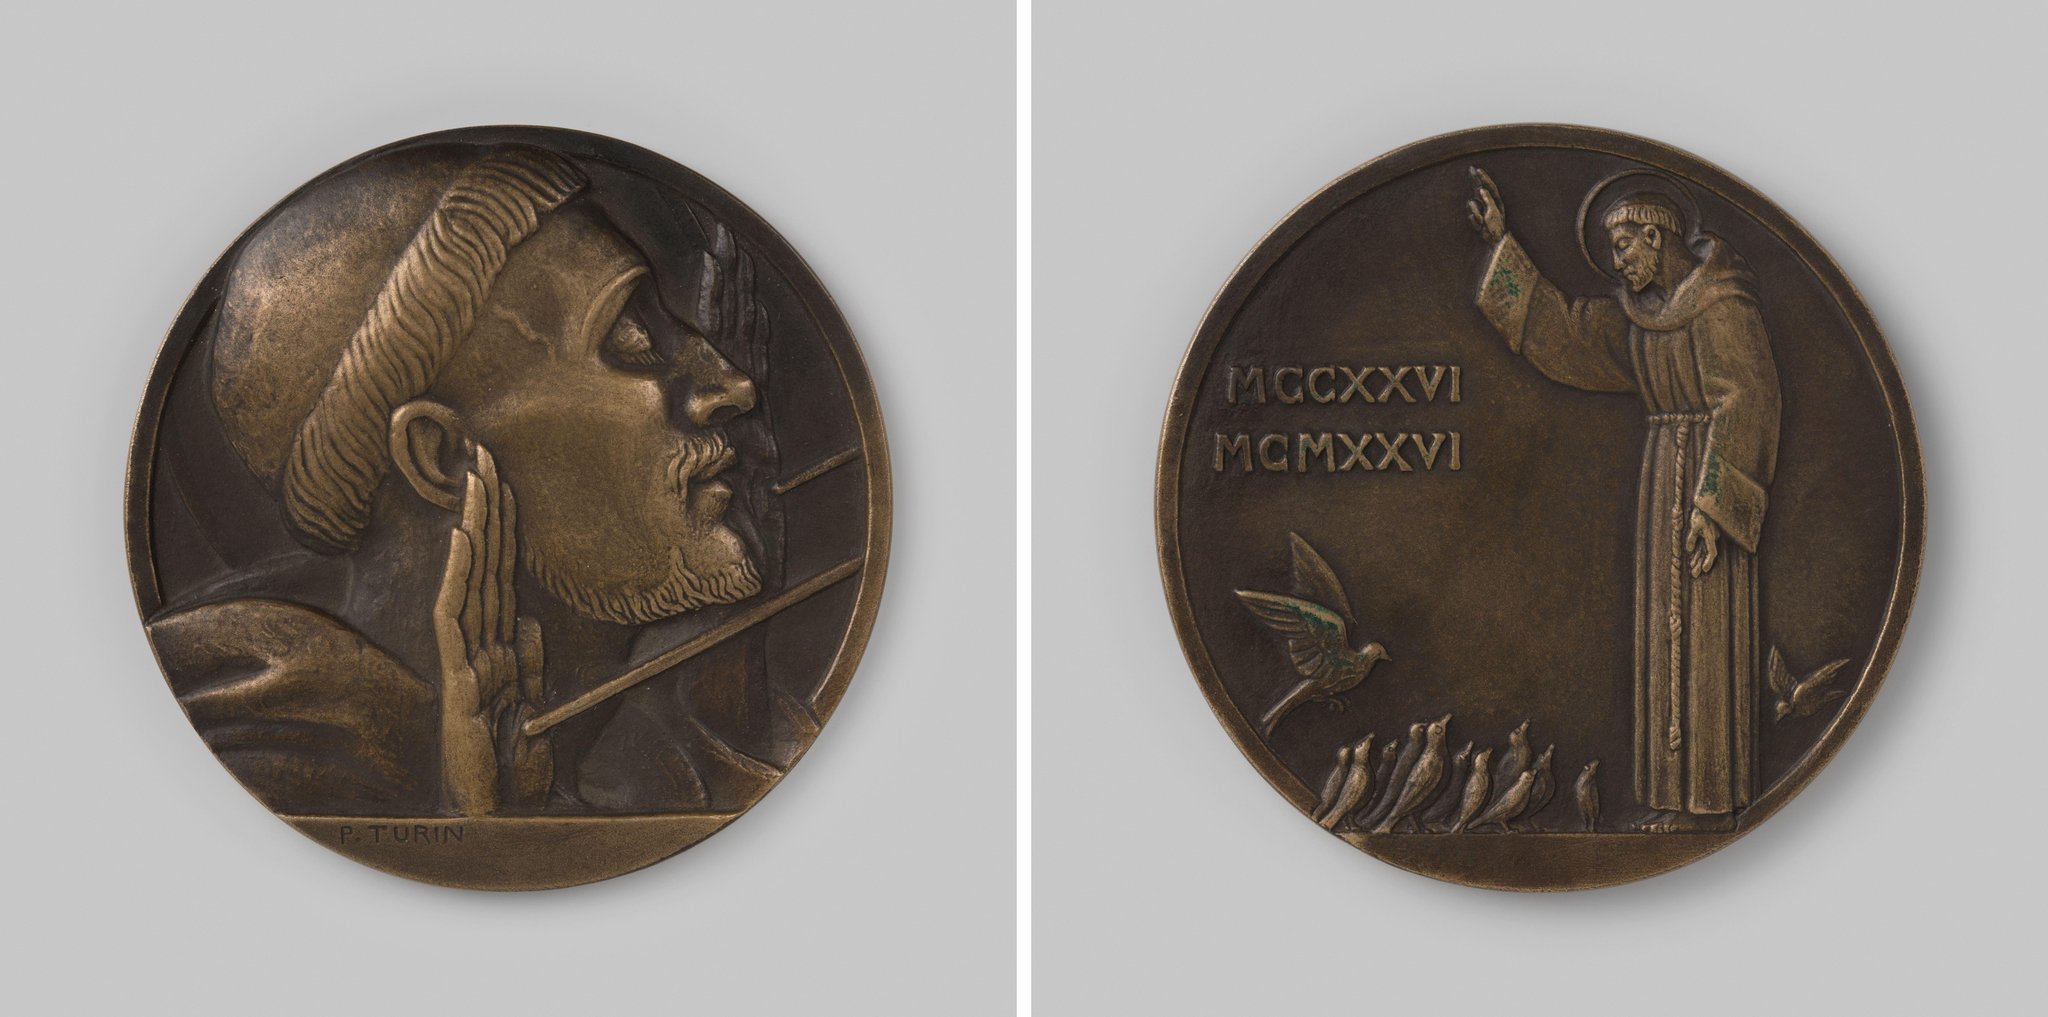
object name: history medal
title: De Heilige Franciscus 1226-1926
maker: pierre turin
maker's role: medailleur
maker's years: 1891-1968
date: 1926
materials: bronze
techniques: casting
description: Bronzen penning, op de voorzijde de afbeelding van Franciscus naar rechts, op de keerzijde Franciscus prekend voor de dieren, links twee jaartallen.